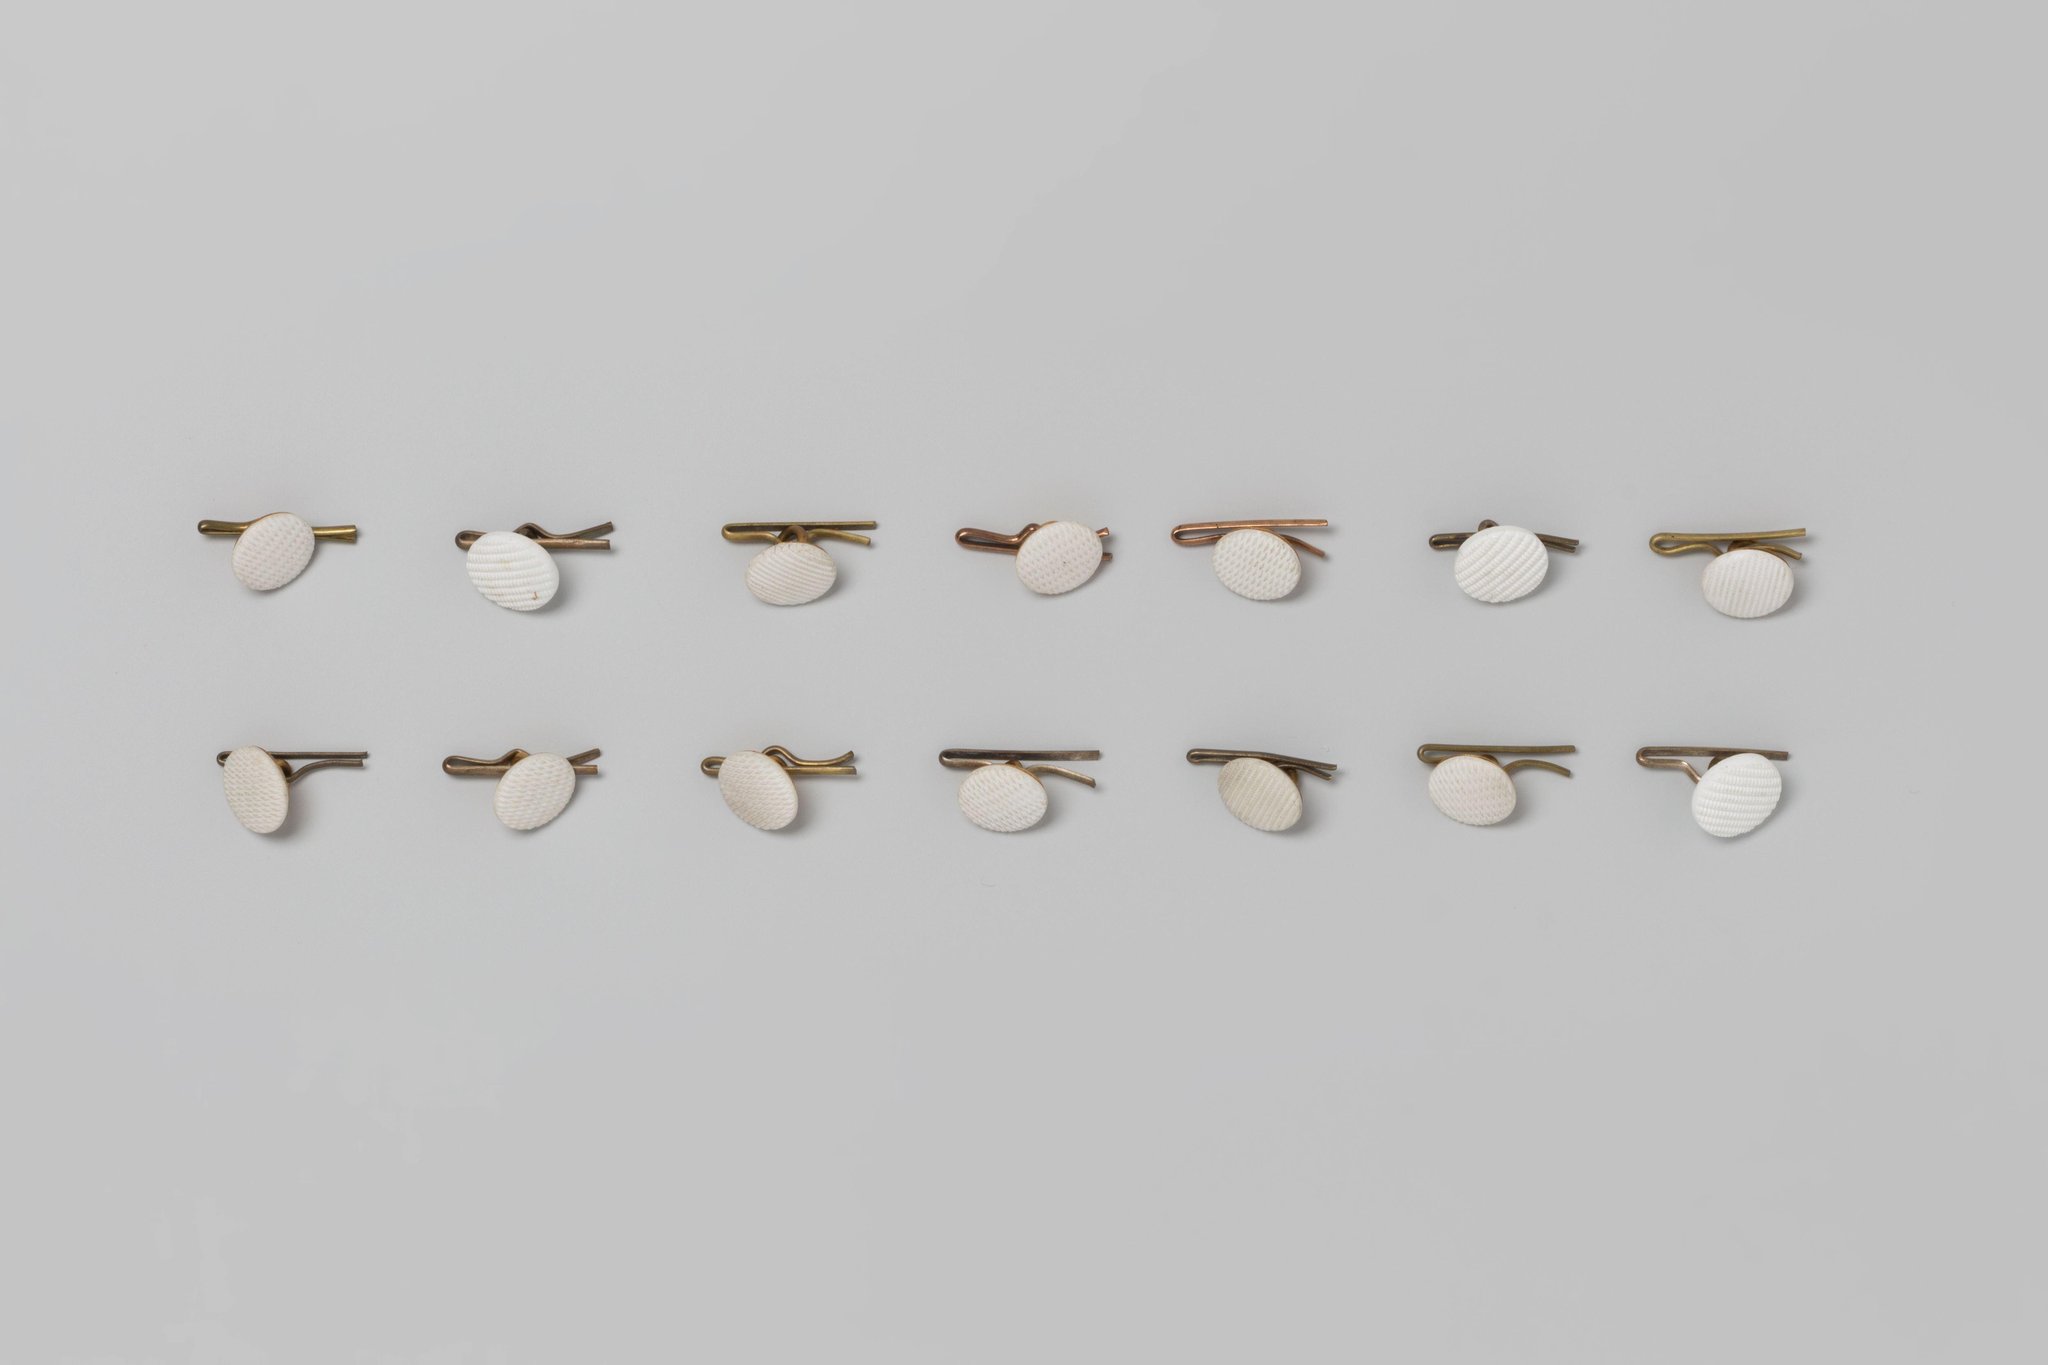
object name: vestknoop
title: Vestknoop van kunststof met reliëf-ribbel, vast oogje en losse tegenklem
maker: Anonymous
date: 1900-1940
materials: metal, plastic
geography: netherlands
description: Vestknoop van kunststof met reliëf-ribbel, vast oogje en losse tegenklem.